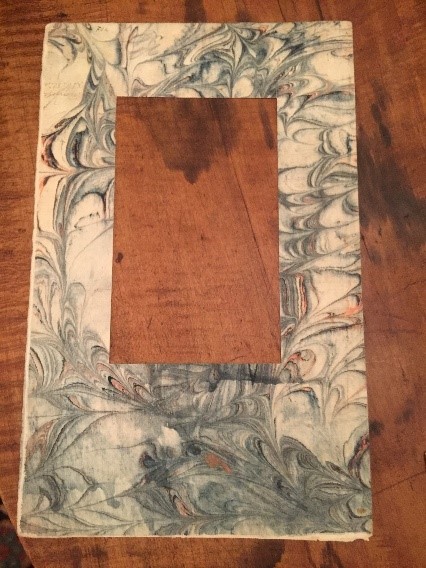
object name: folio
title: Folio Decorated with Marbling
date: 1701-1800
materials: ink, pigment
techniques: marbling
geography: iran